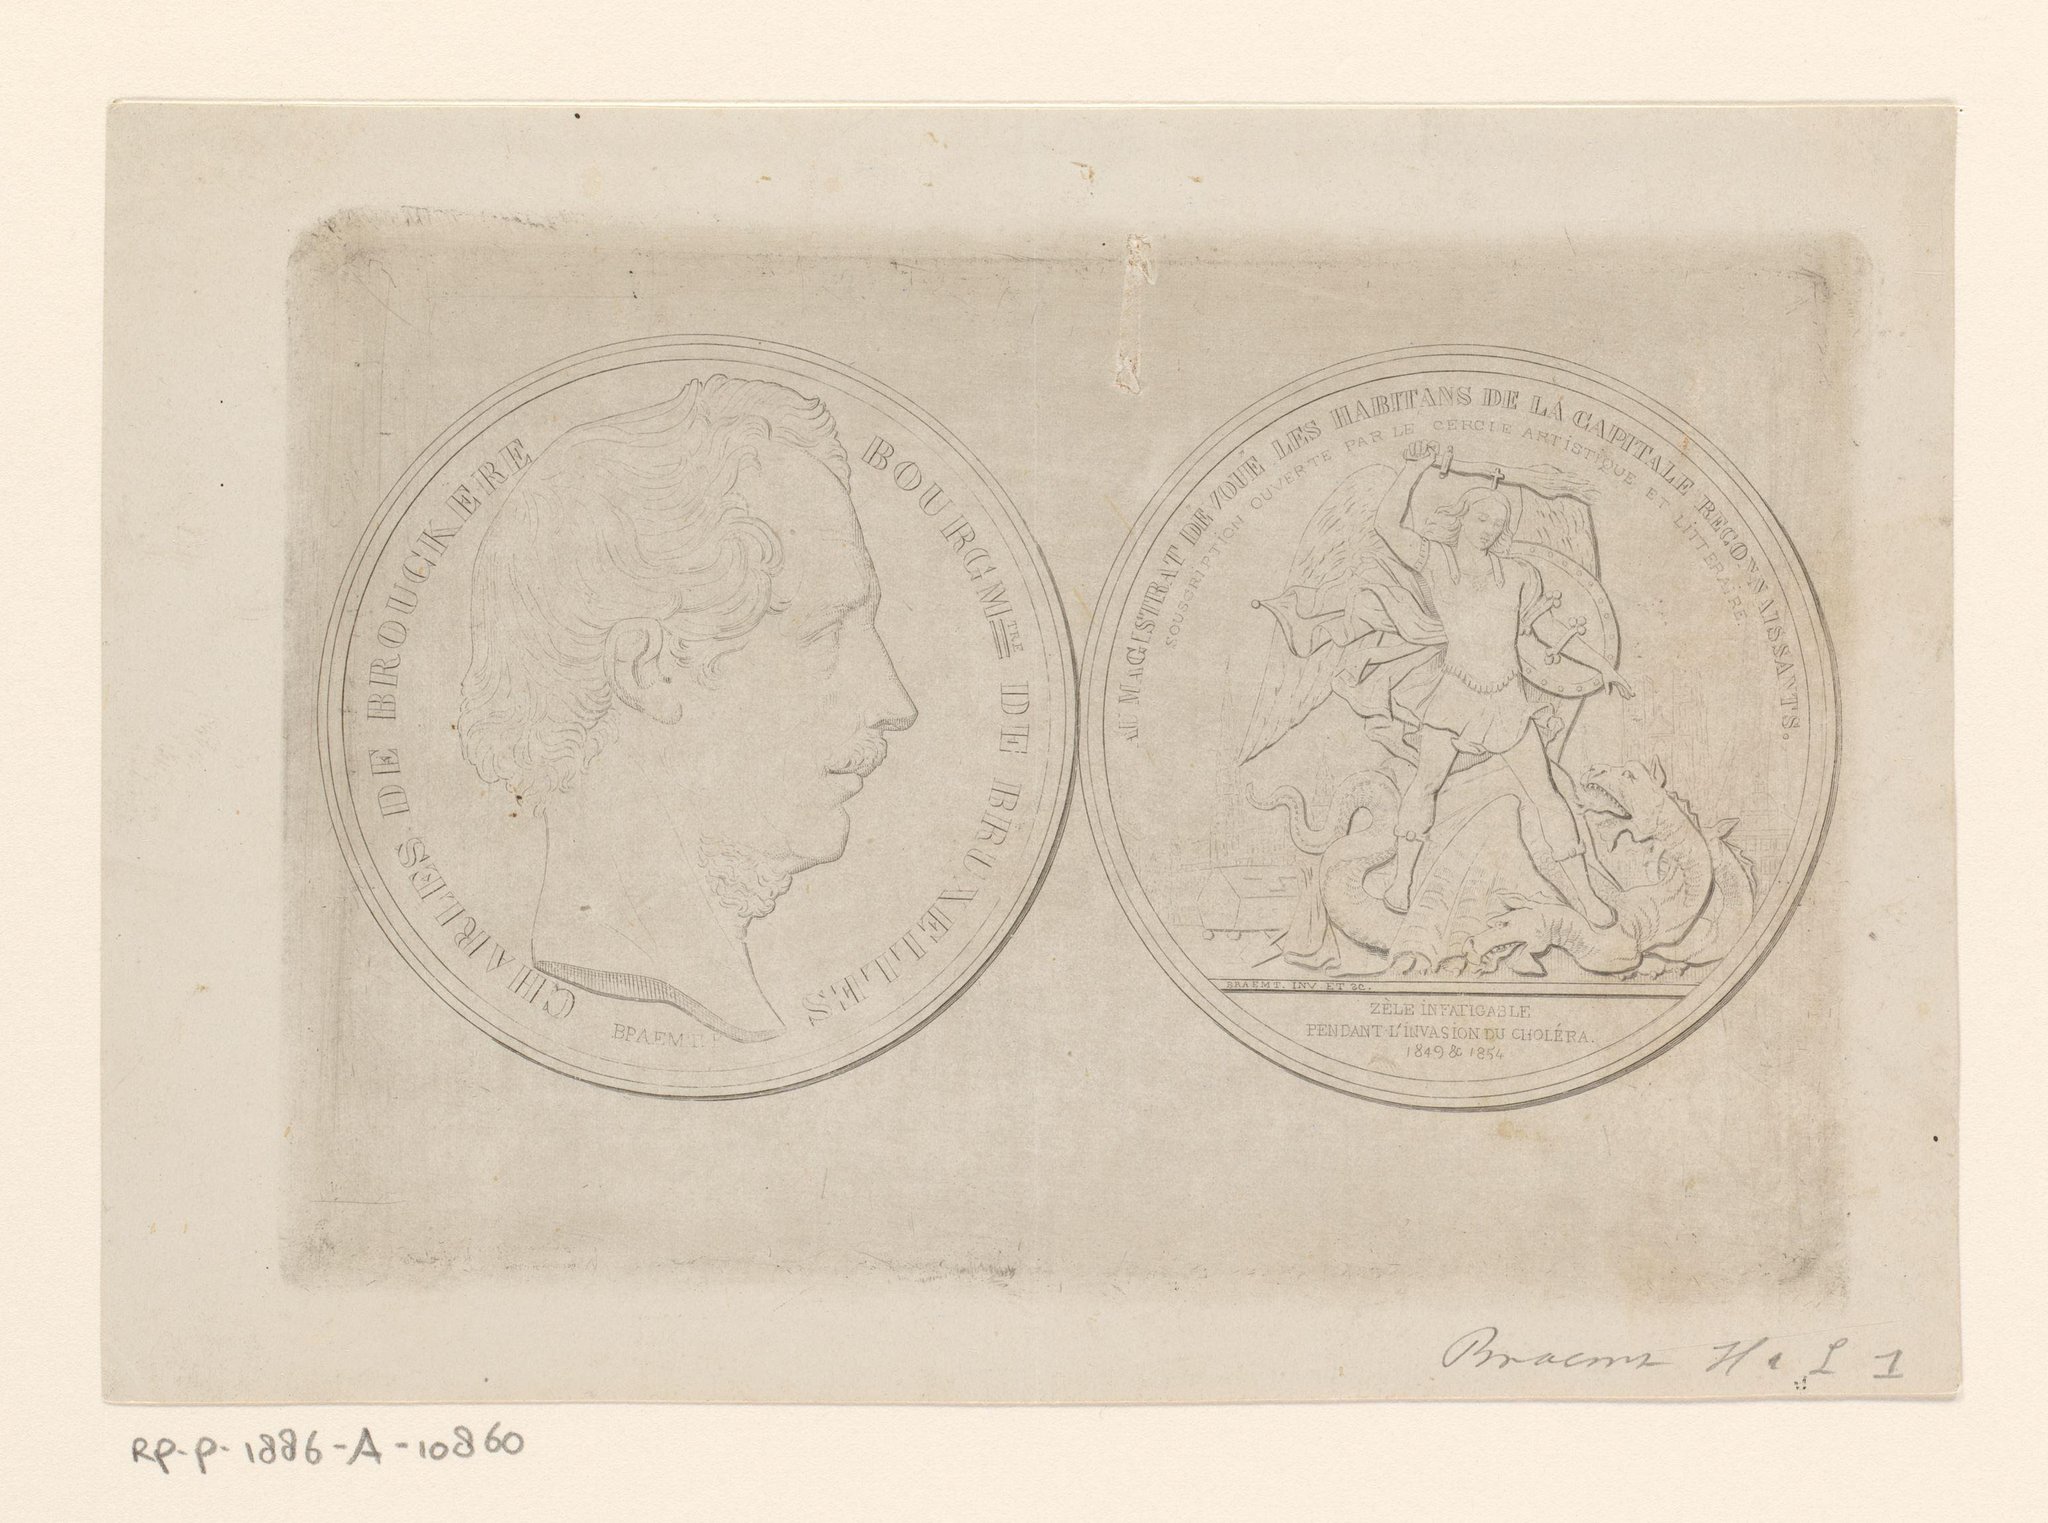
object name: print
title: Medaille aangeboden aan Charles de Brouckère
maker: joseph pierre braemt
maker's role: print maker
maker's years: 1796-1864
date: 1854-1864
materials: paper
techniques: etching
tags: bruges, brussels, mayor, head (human), the warrior martyr george (georgius); possible attributes: banner (red cross on white field), (red) cross, dragon, (white) horse, broken lance, shield (with cross), sword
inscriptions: collector's mark: Lugt 2228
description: Medaille aangeboden aan Charles de Brouckère. Op een zijde een portret en profil van Charles de Brouckère. Op de andere zijde Sint Joris die de draak verslaat.